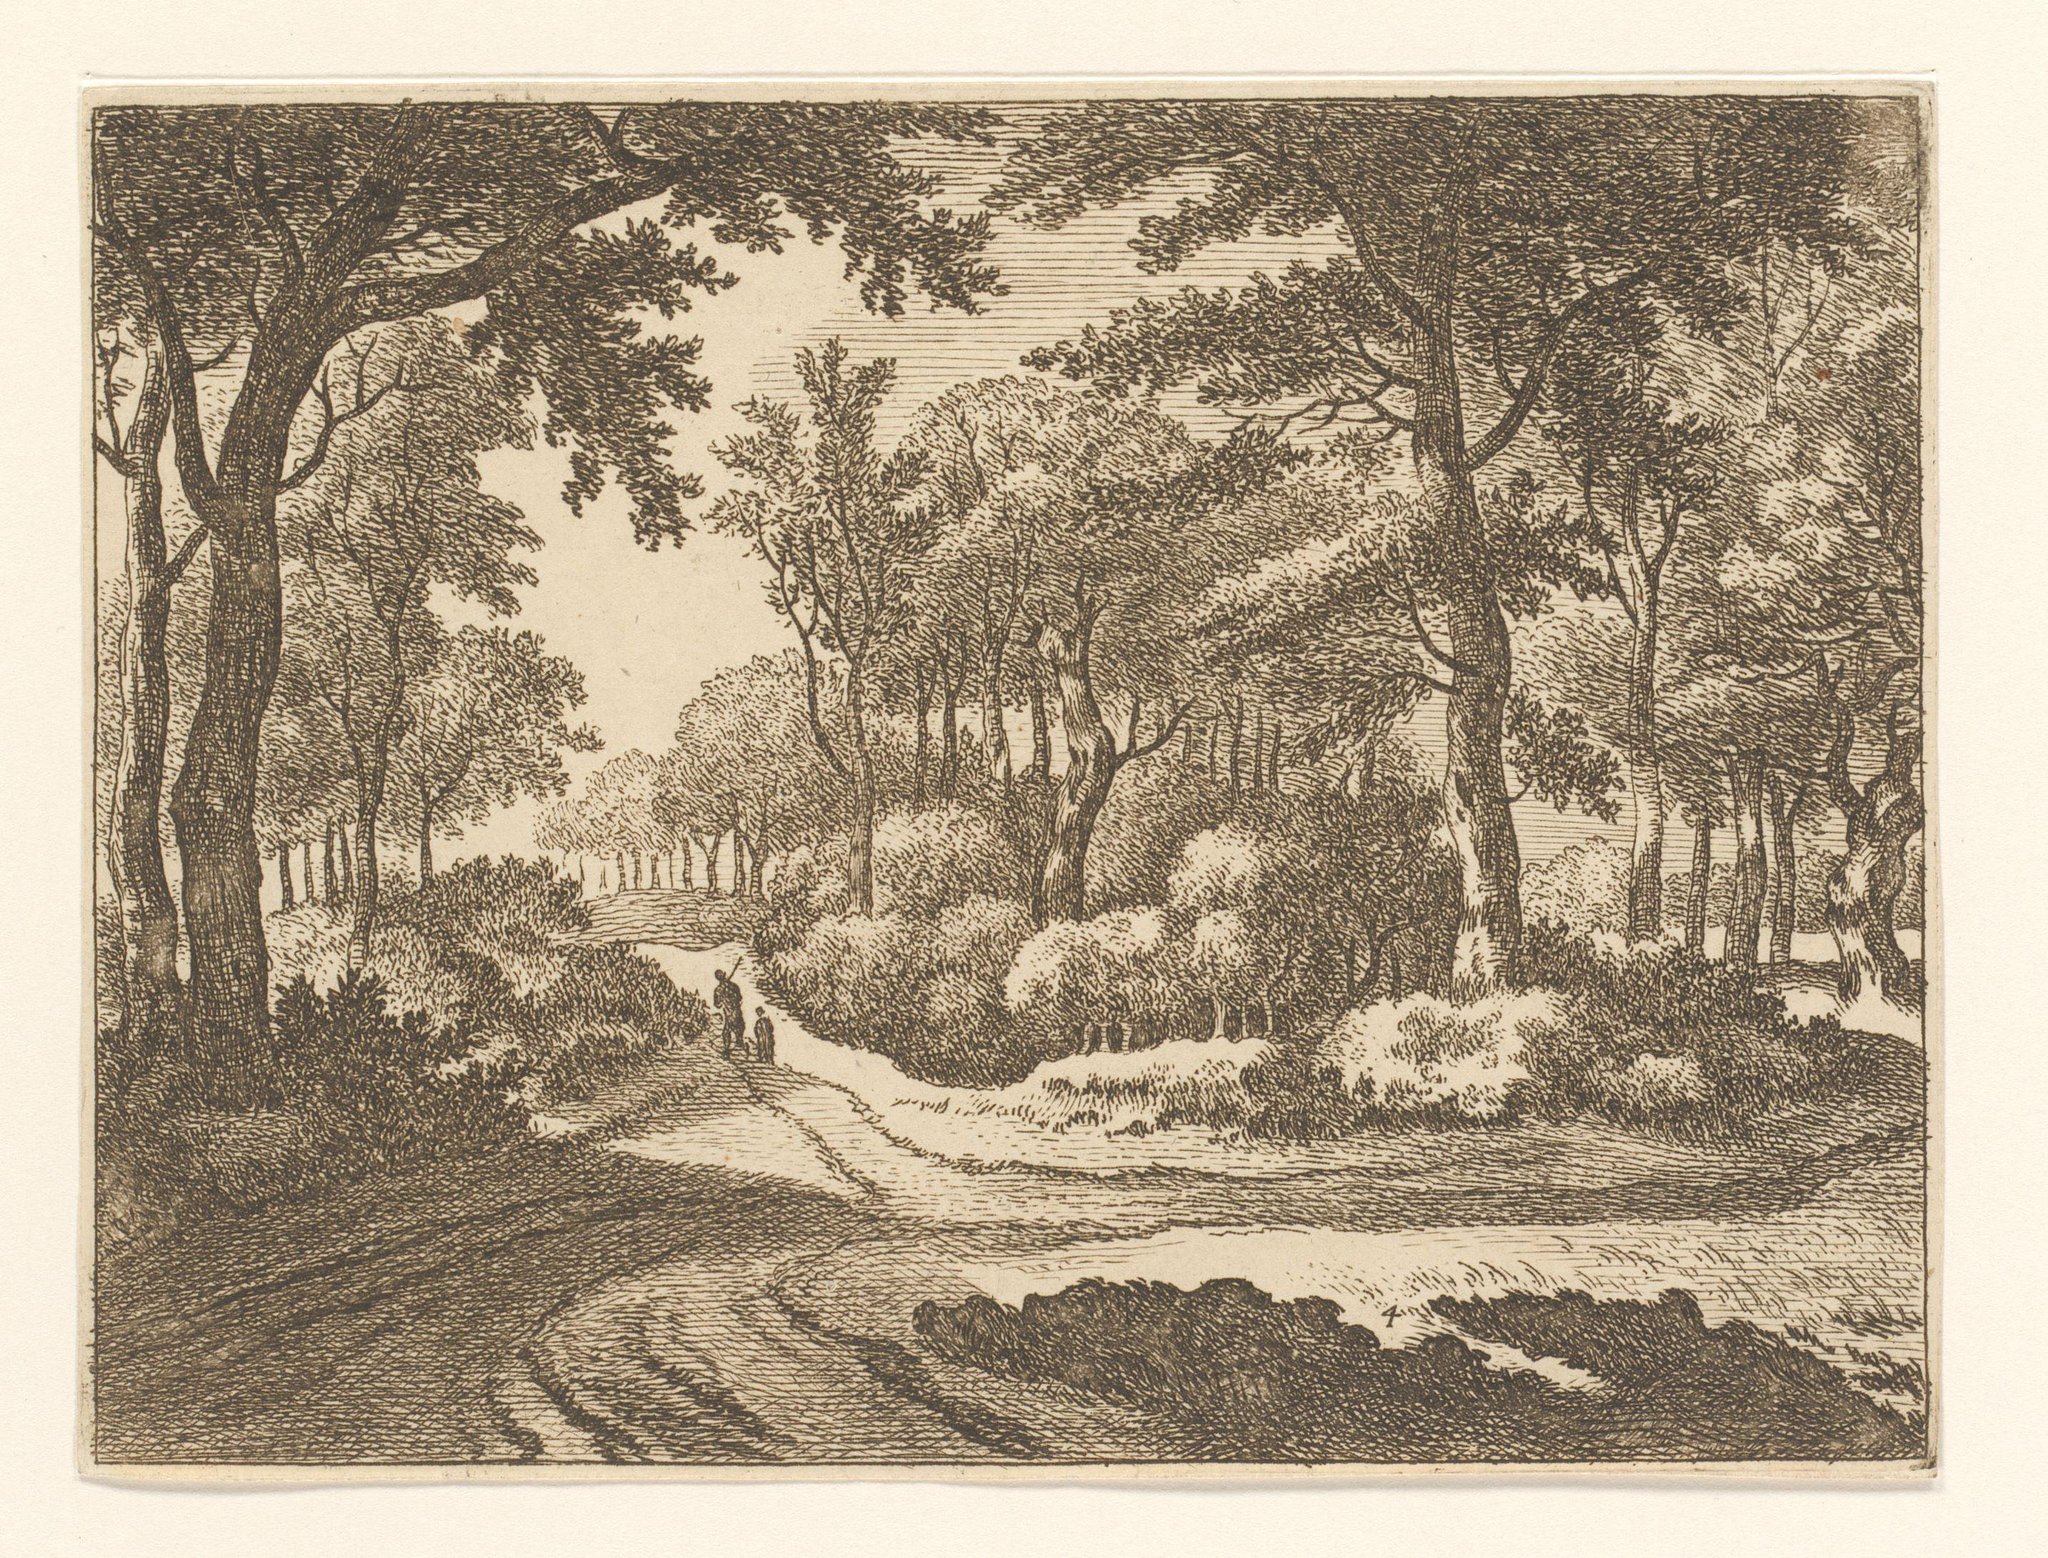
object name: print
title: Boslandschap met twee figuren op een pad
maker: Anonymous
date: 1700-1799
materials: paper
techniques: etching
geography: netherlands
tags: forest, wood